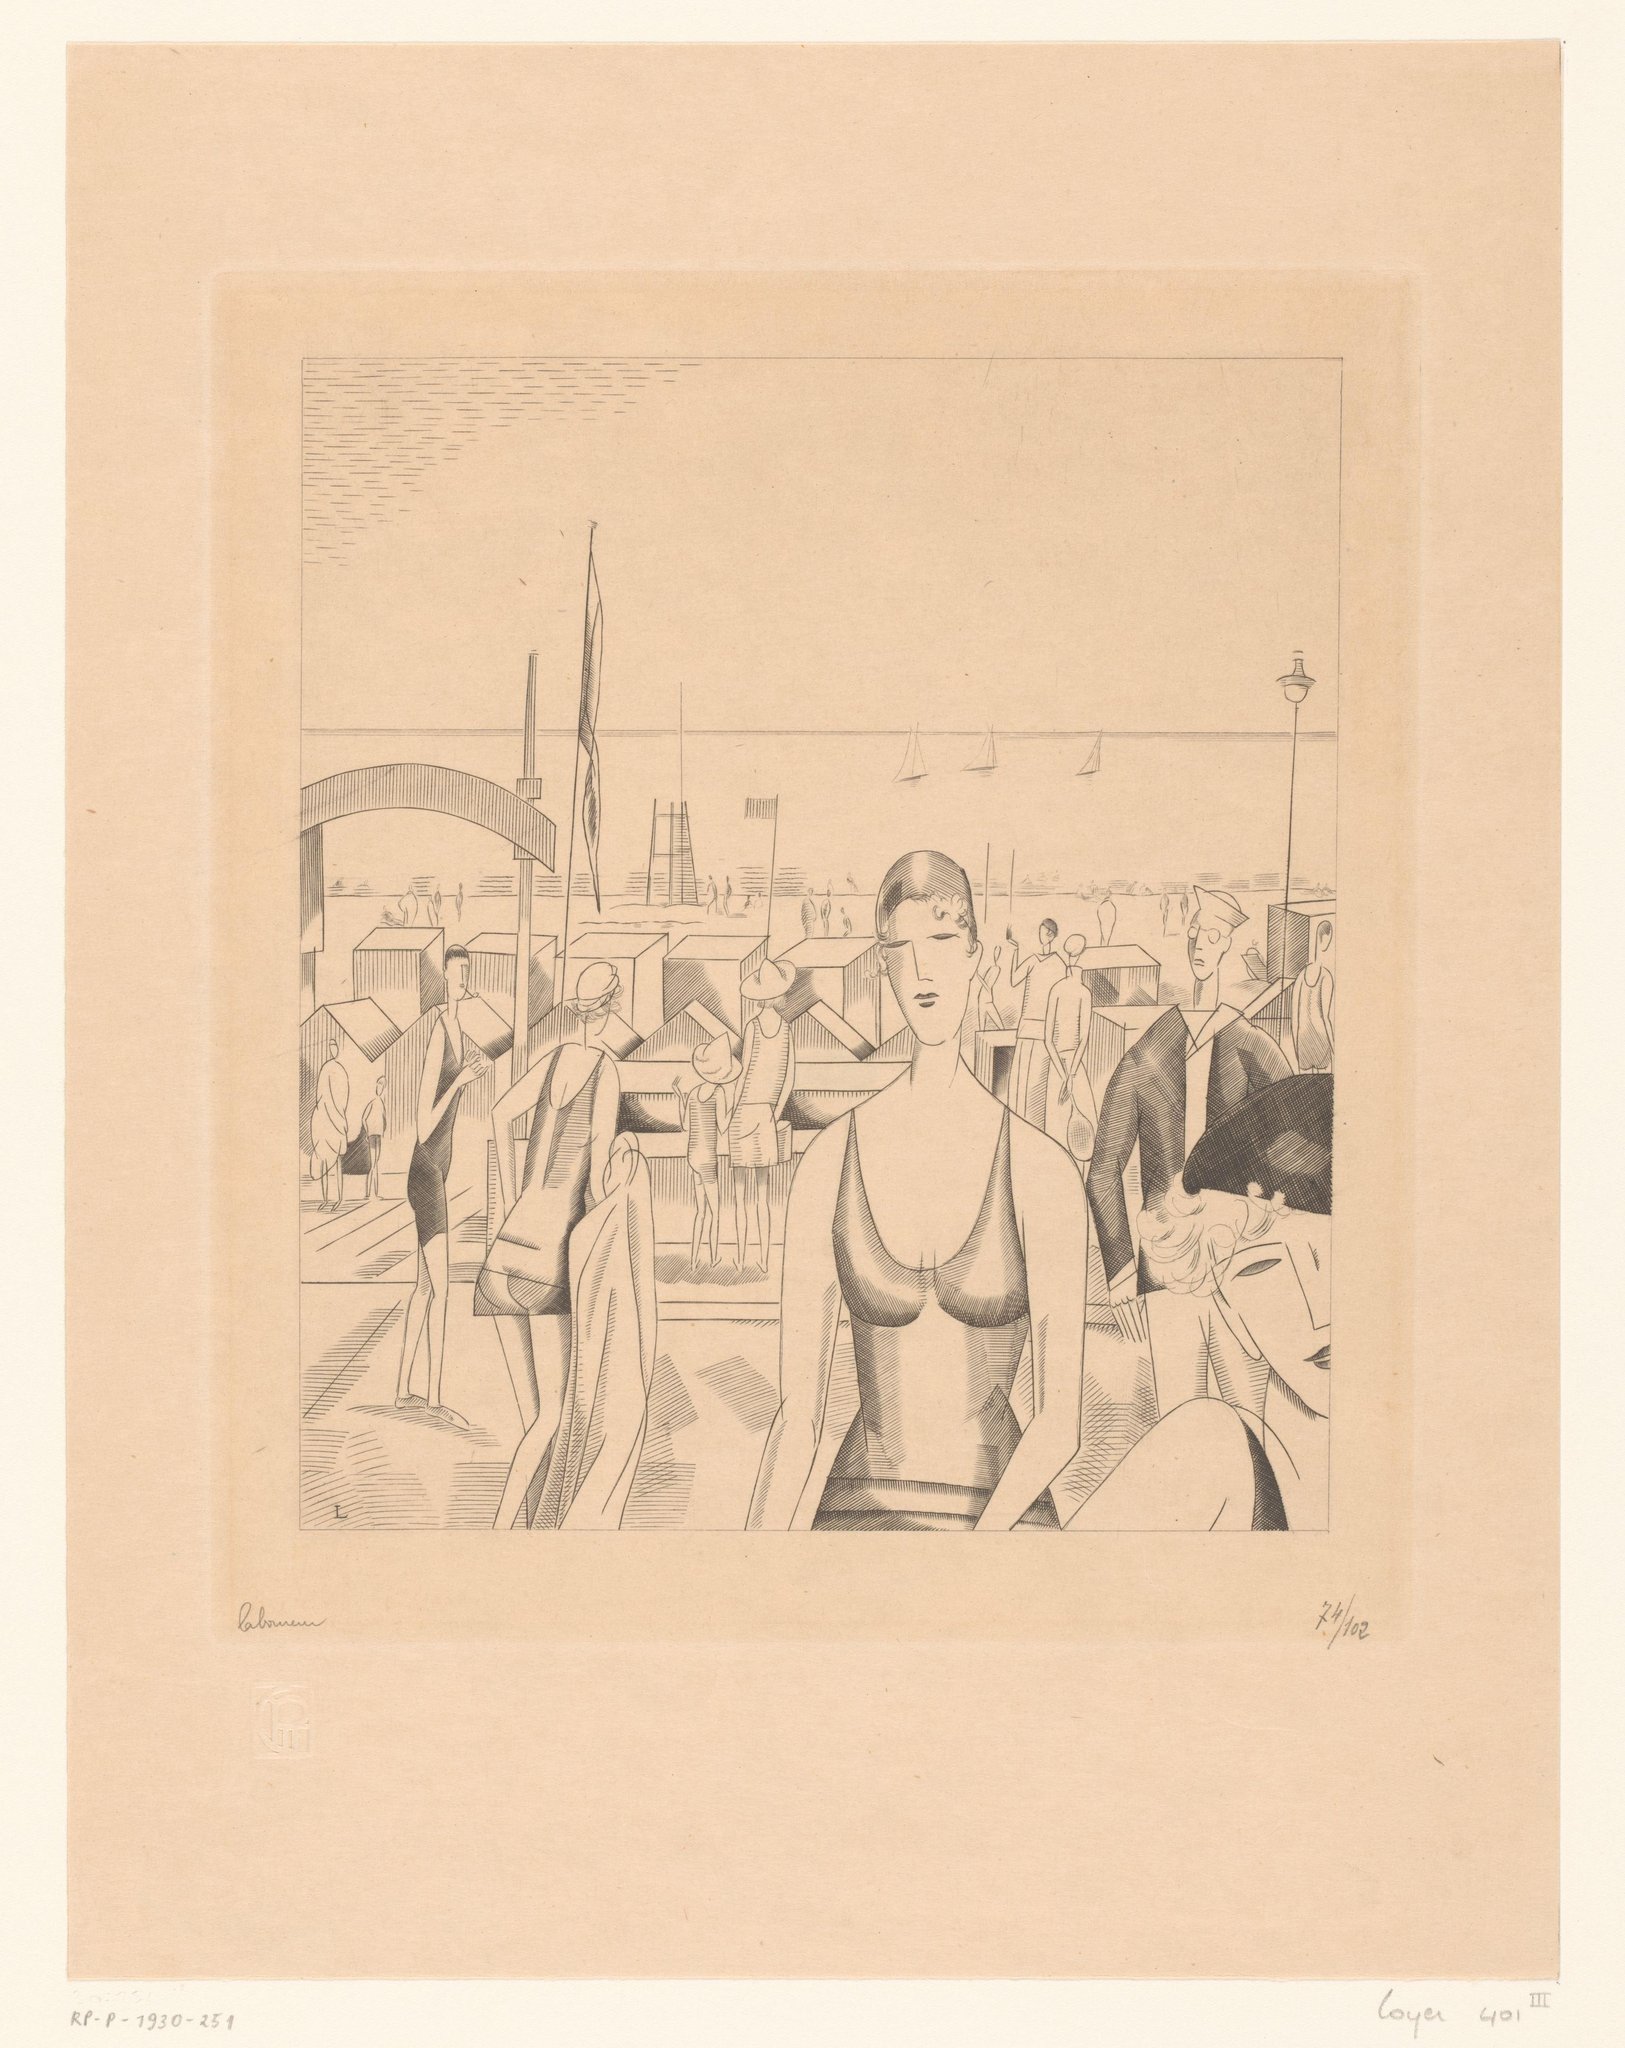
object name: print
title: Badplaats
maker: jean emile laboureur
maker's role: draughtsman, print maker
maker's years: 1877-1943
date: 1887-1930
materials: paper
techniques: drypoint, engraving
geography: france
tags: beach (as place of recreation)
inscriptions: check stamp: Lugt 1195a, collector's mark: Lugt 2228